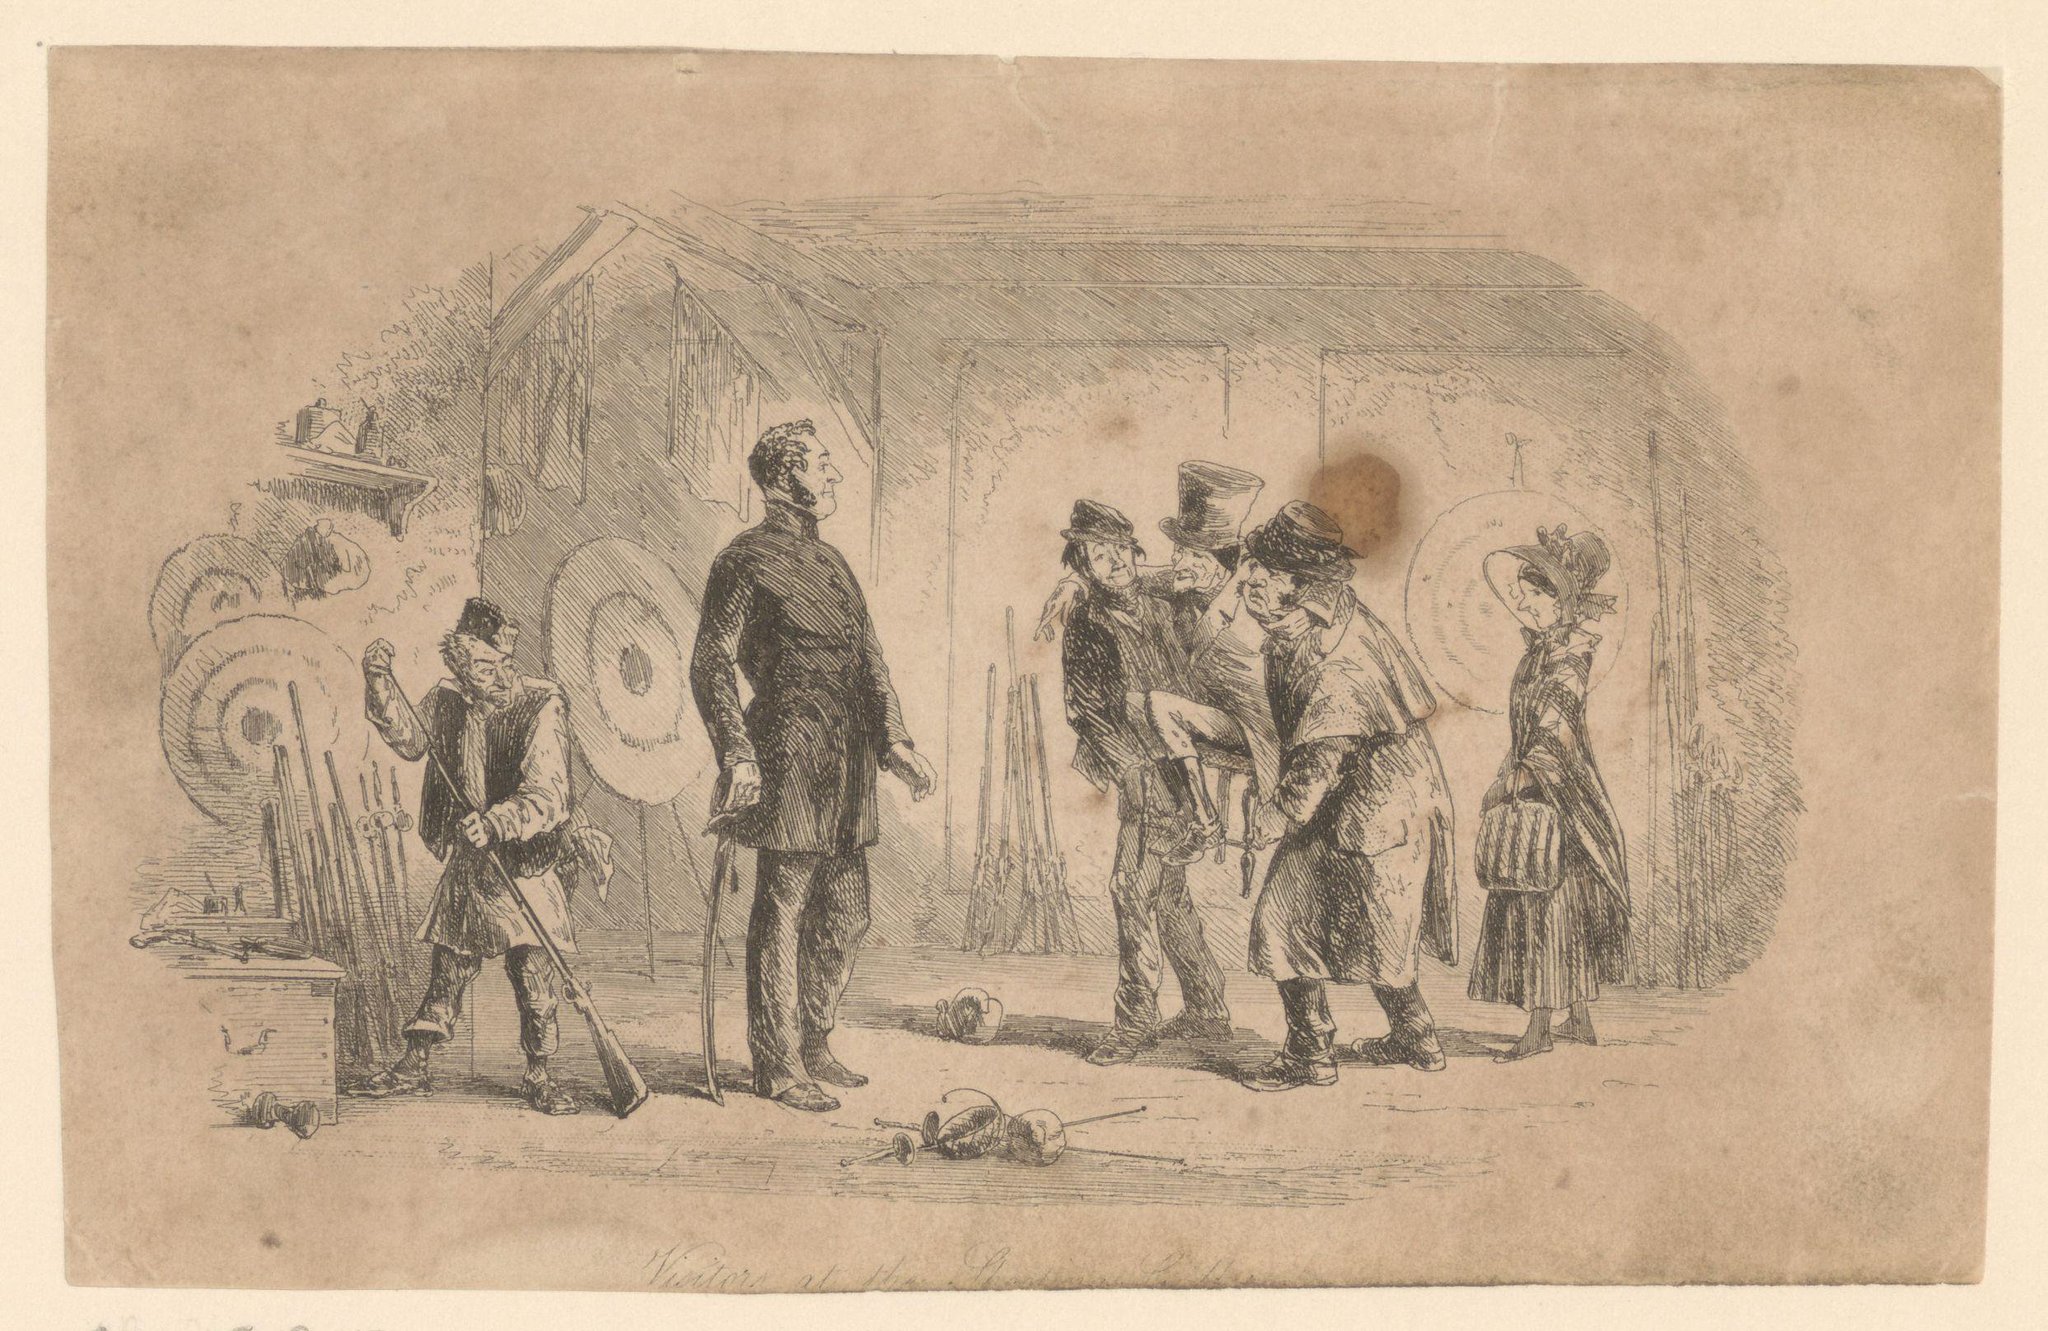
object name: book illustration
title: Grootvader Smallweed bezoekt George Rouncewell in zijn schiettent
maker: hablot knight browne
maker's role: print maker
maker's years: 1815-1882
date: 1853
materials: paper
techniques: etching, letterpress printing, roulette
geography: london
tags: carrying a person, shooting gallery, miniature rifle range (~ pleasure fair)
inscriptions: collector's mark: Lugt 2228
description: Prent uit: Dickens, Charles. Bleak House. Londen: Bradbury & Evans, 1853, p. 261.